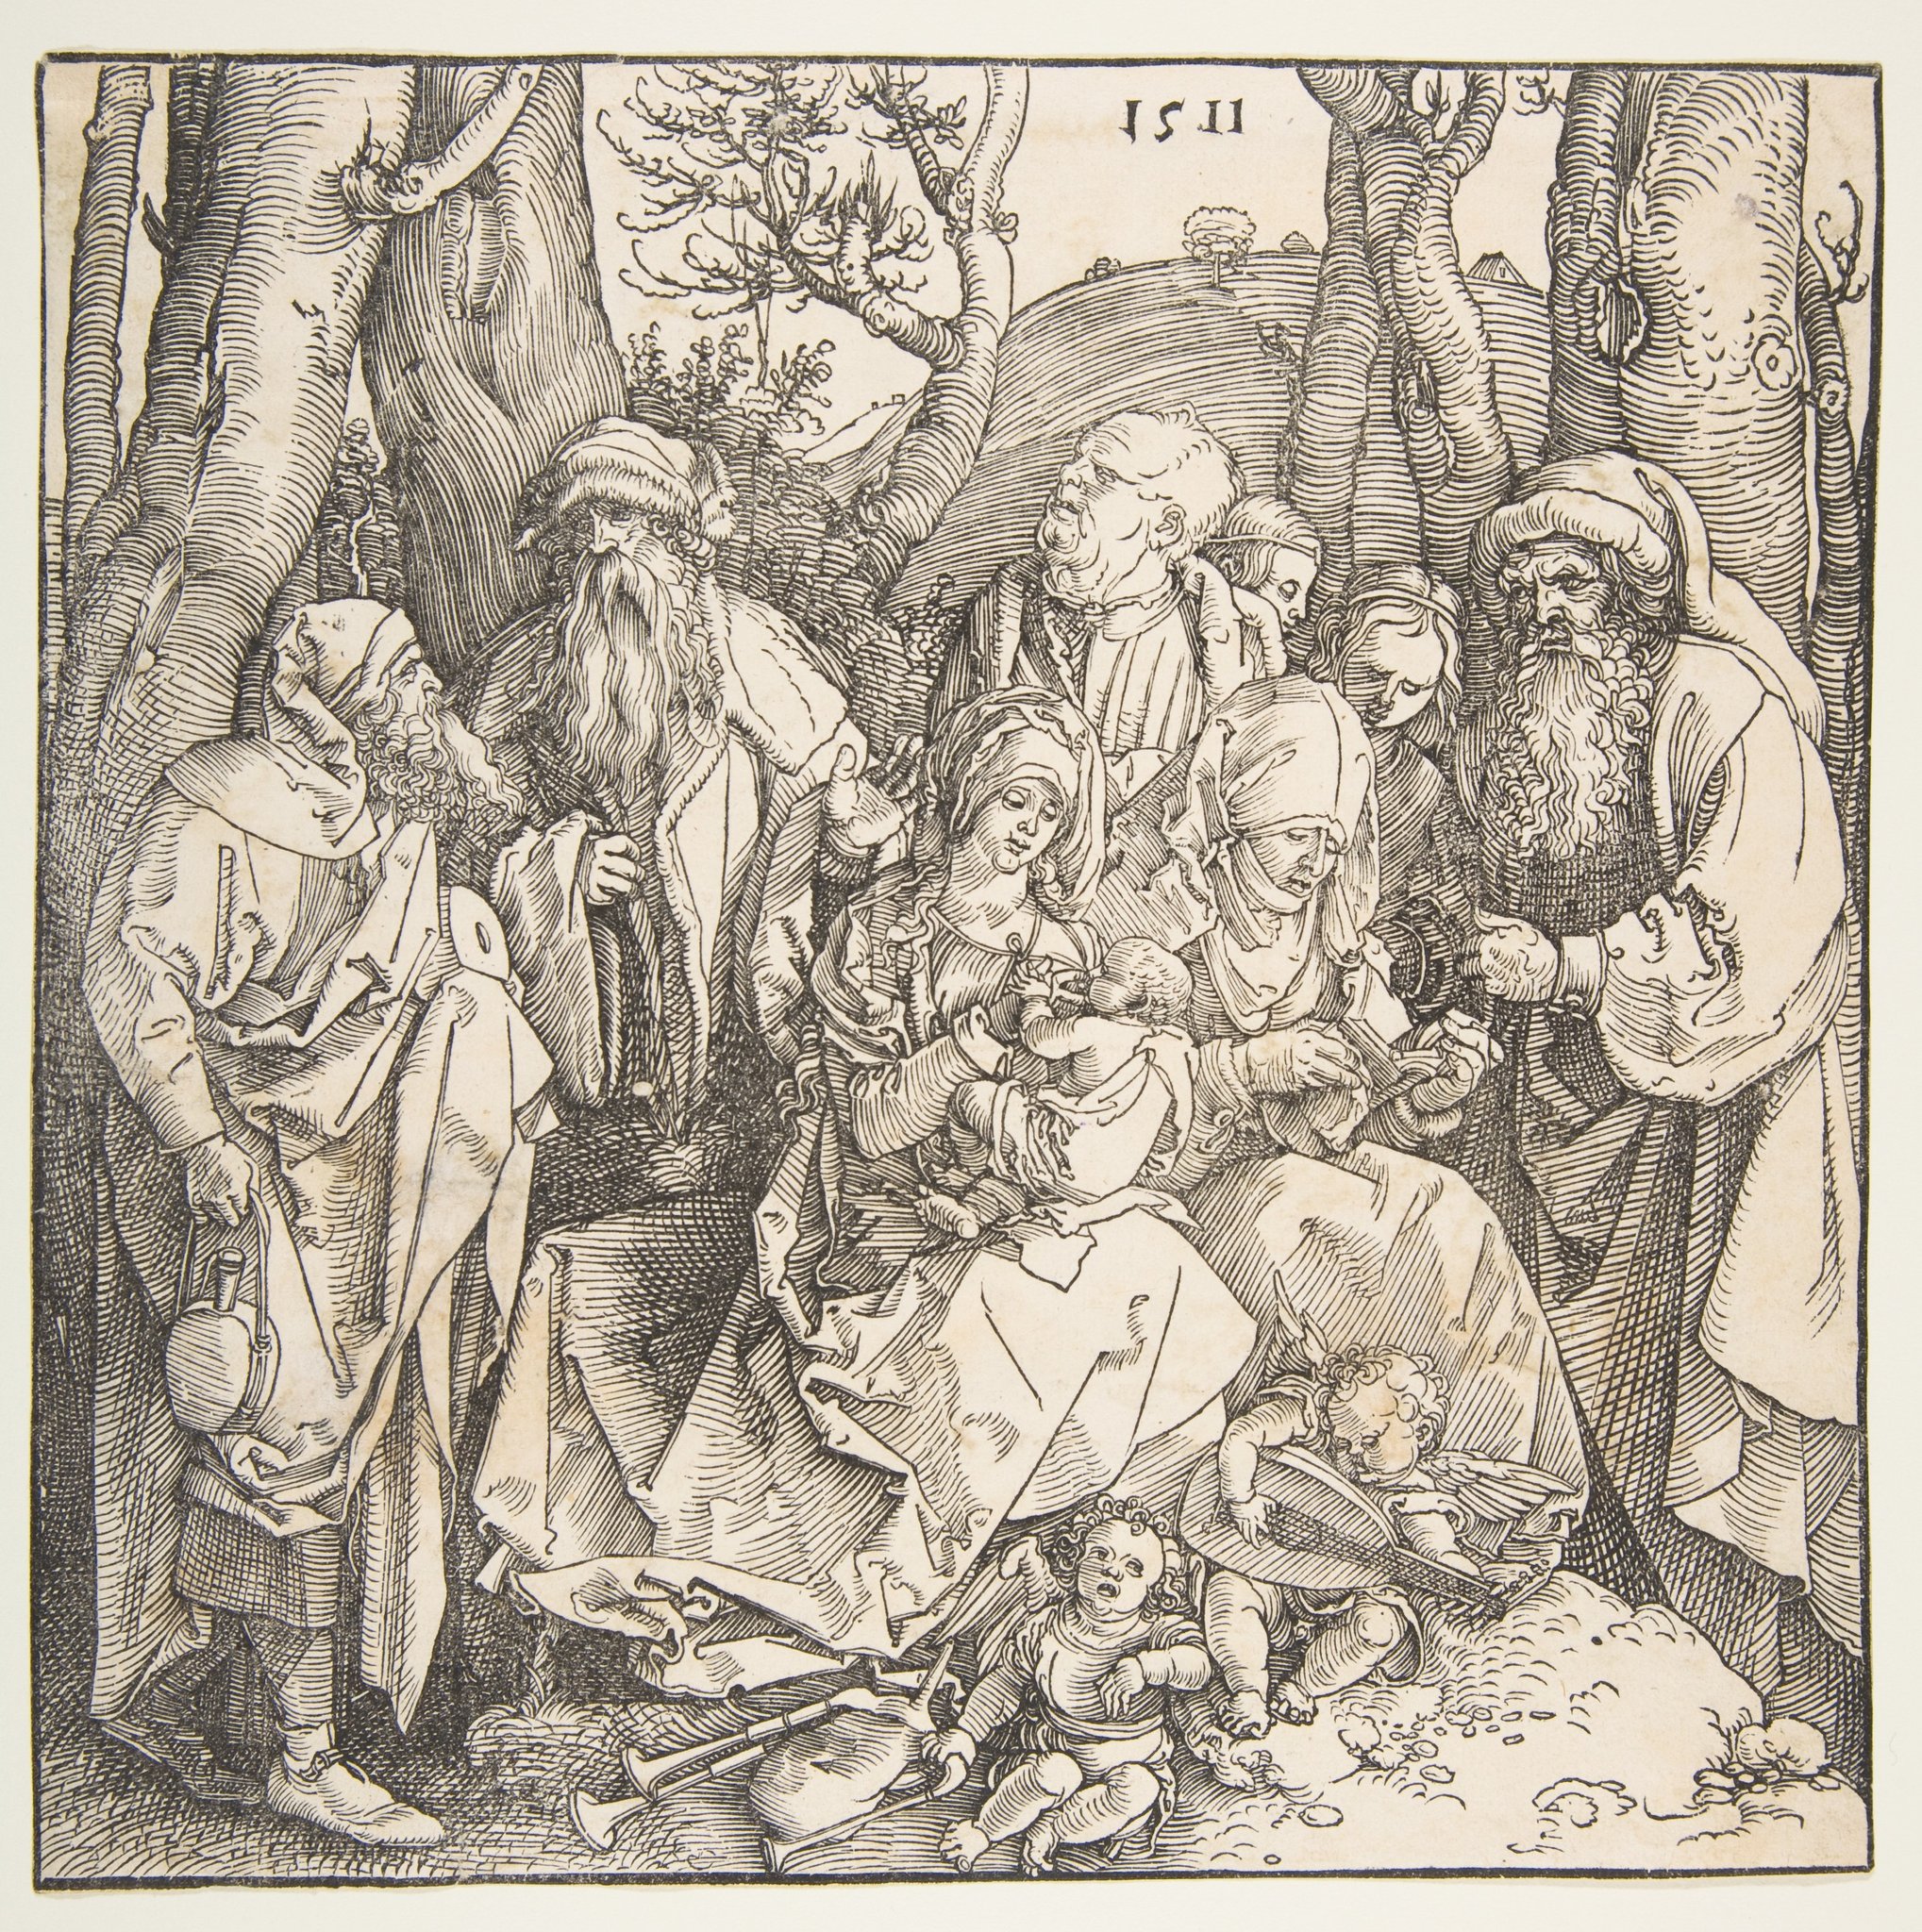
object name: print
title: The Holy Family with Saints and Two Musical Angels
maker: albrecht dürer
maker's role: artist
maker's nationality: german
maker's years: 1471-1528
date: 1511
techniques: woodcut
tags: musical instruments,angels,holy family,madonna and child,saints